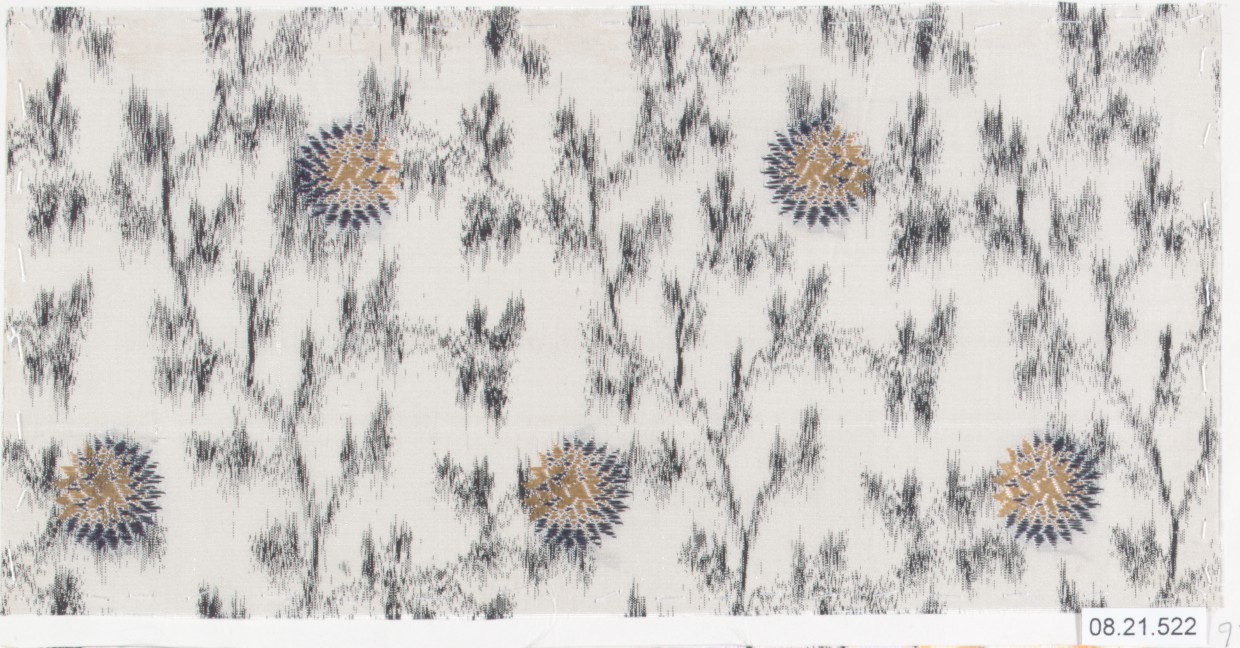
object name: textile sample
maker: Anonymous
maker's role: designer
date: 1900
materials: silk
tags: flowers